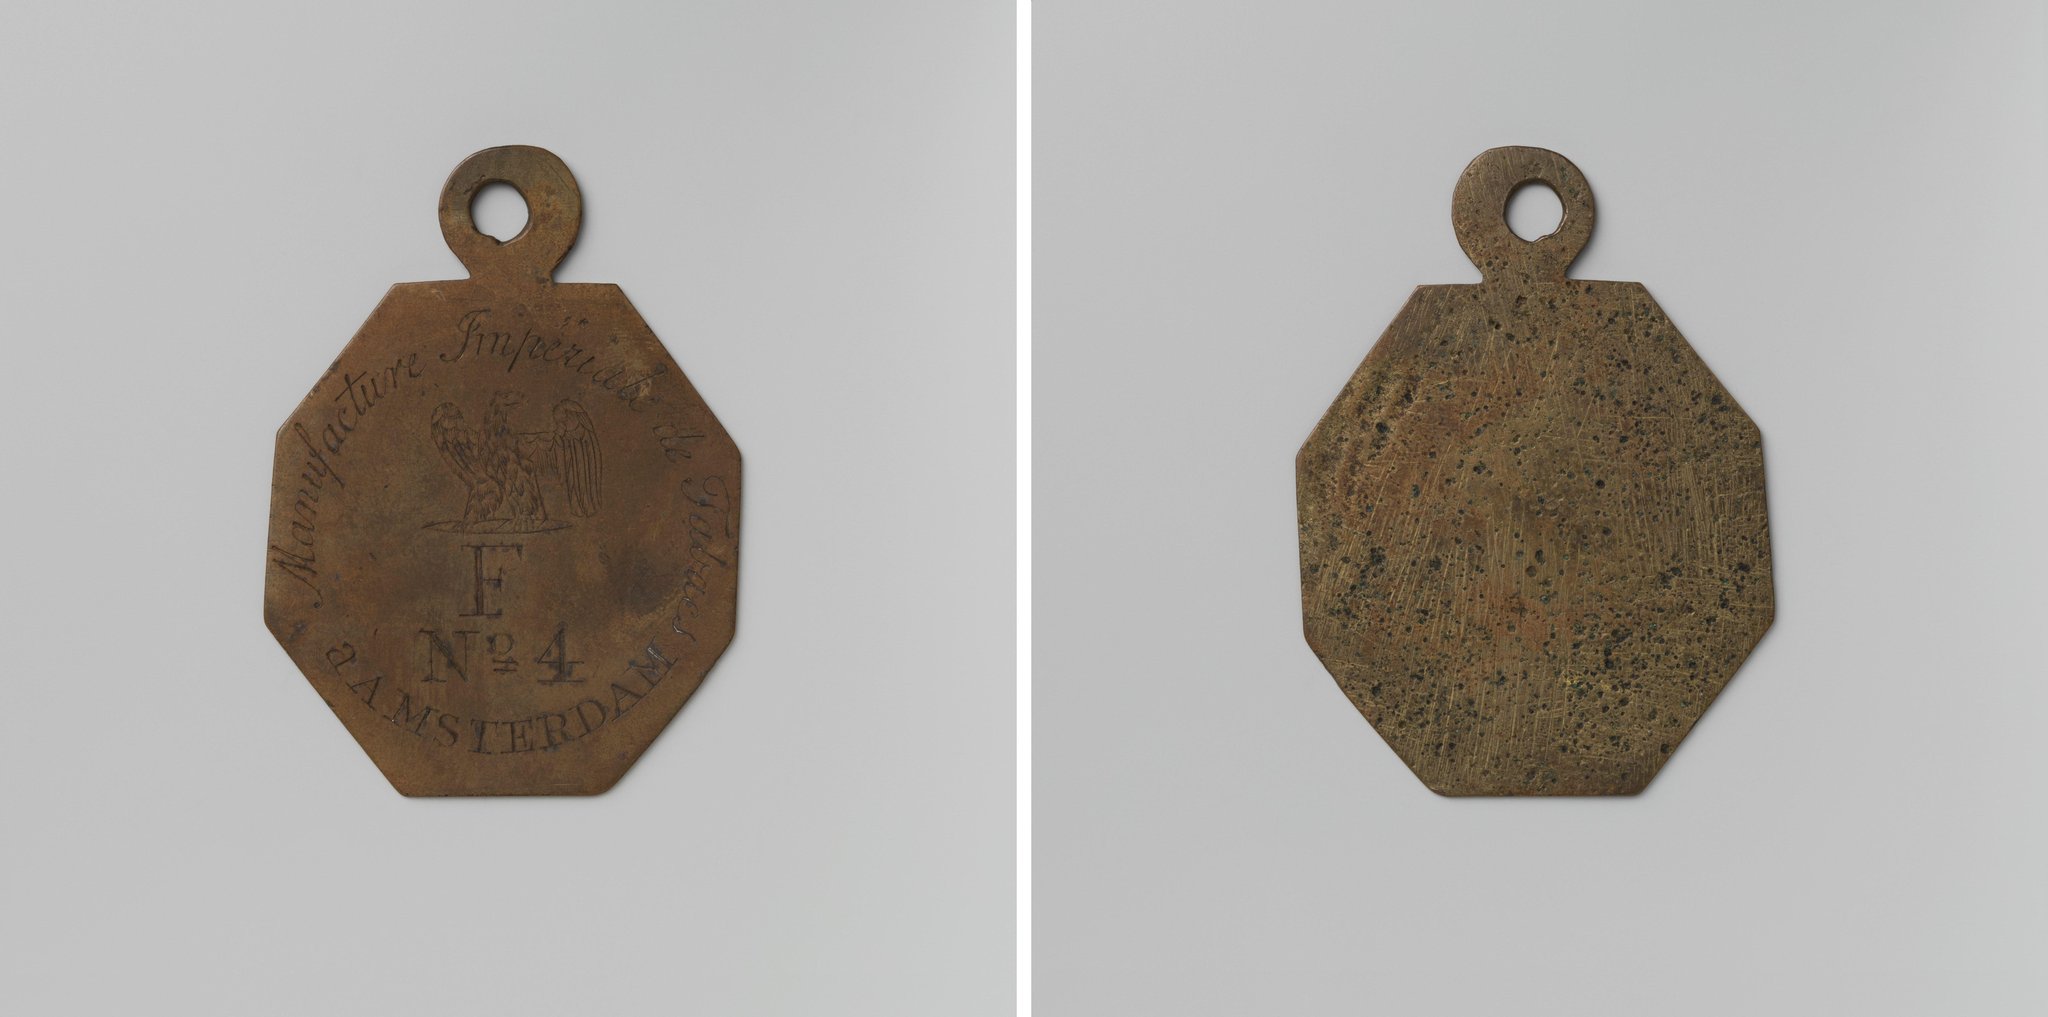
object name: insignia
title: Manufacture Imperiale de Tabacs te Amsterdam, draagteken, gedragen door een van de werknemers, met no. F 4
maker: Anonymous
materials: copper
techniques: engraving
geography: amsterdam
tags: amsterdam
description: Eenzijdig koperen achthoekig draagteken aan draagoog. Voorzijde: Franse adelaar boven letter D en opschrift No. 4 binnen omschrift. Keerzijde: blanco.